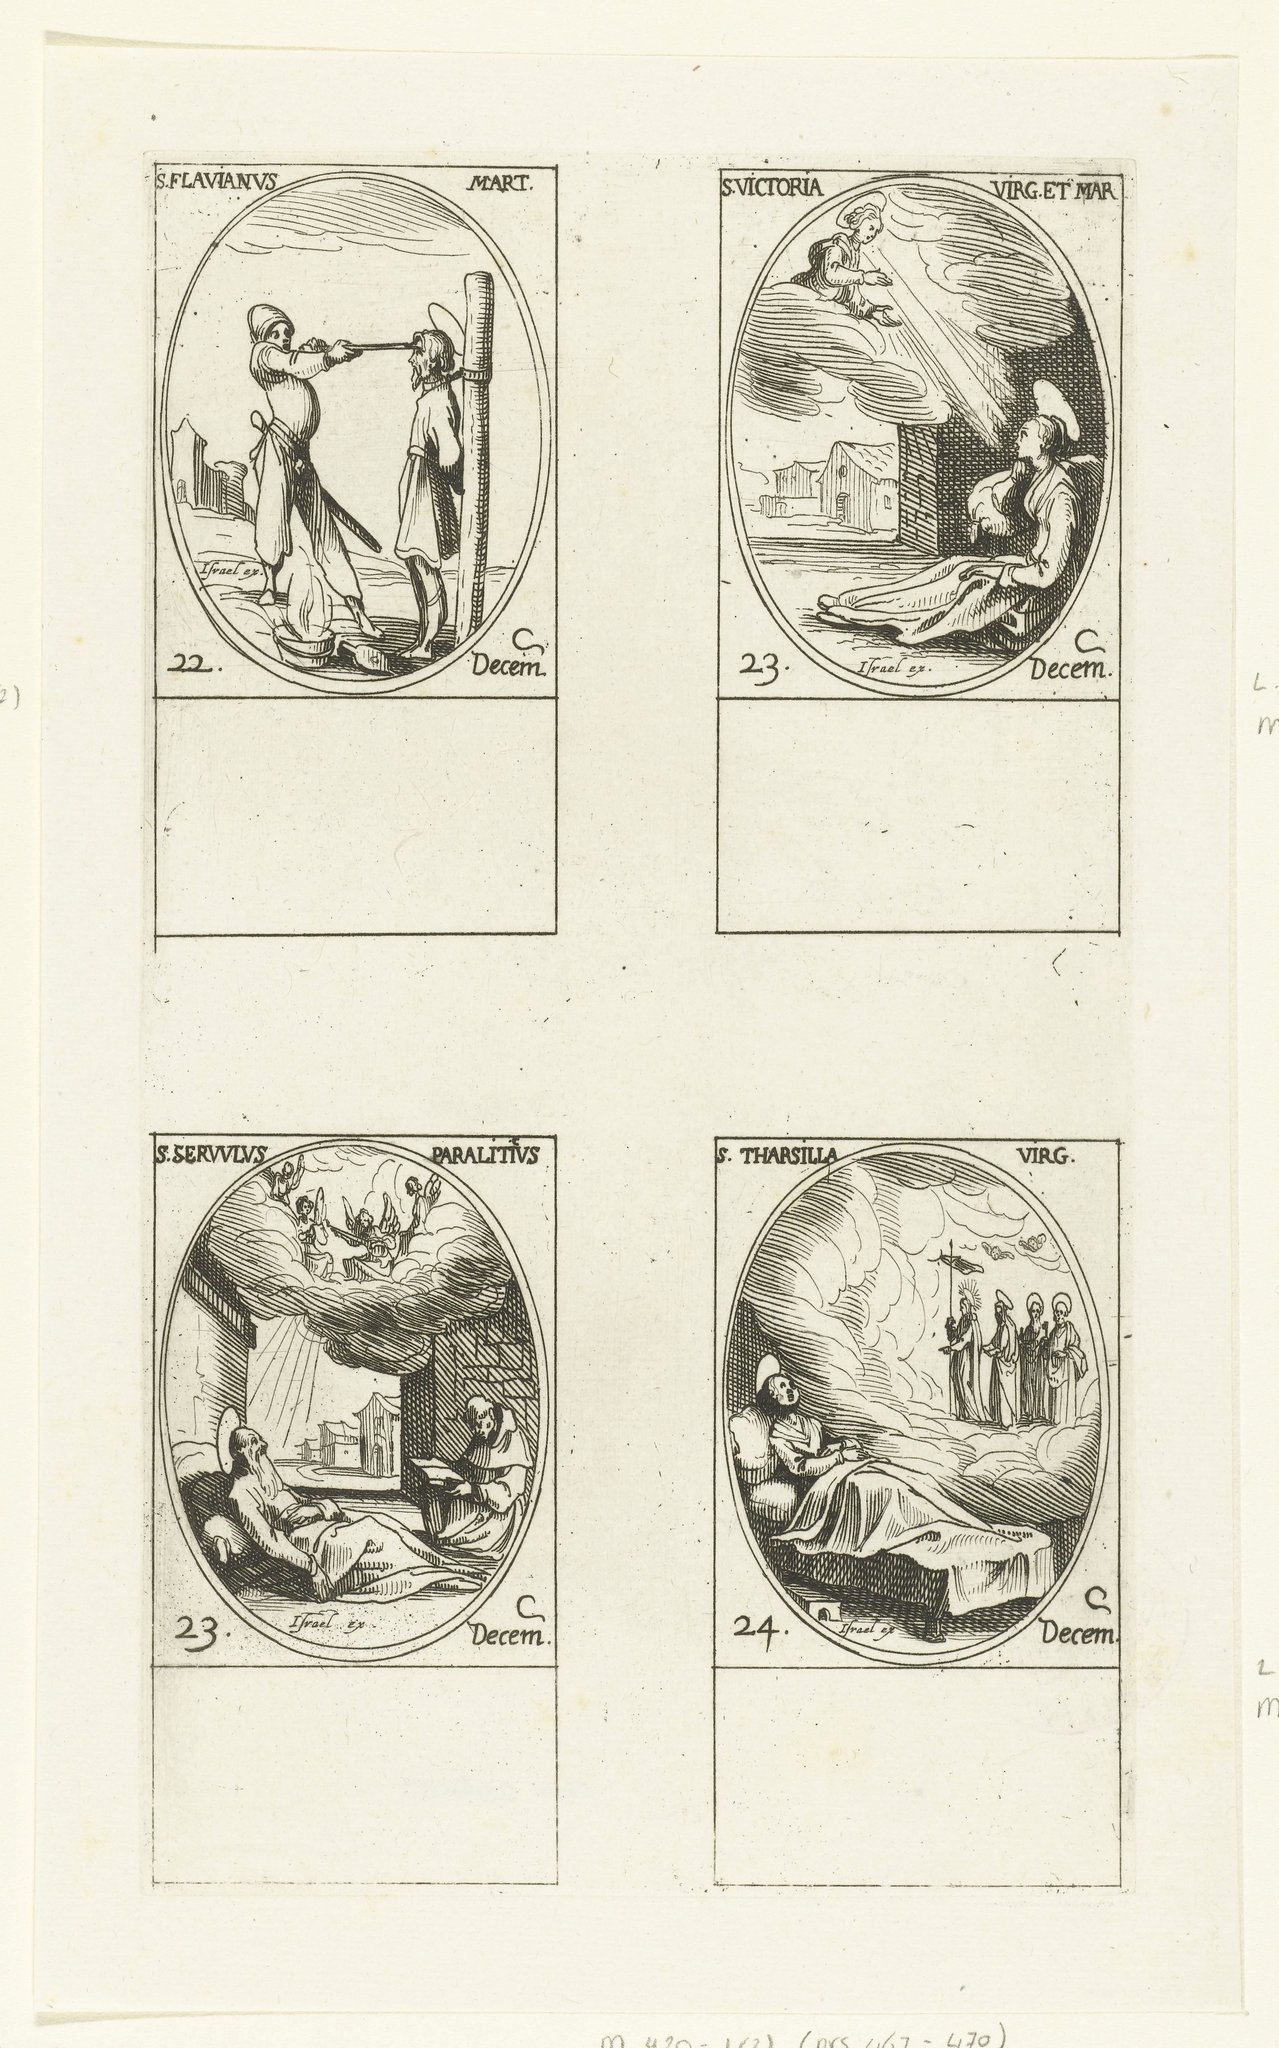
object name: print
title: Alle heiligen en de Christelijke feestdagen van het jaar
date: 1632-1636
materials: paper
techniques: etching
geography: nancy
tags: female saints (with name), male saints (with name)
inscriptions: collector's mark: Lugt 240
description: Blad met vier ovale voorstellingen, elk met opschrift en datum in het Latijn: linksboven de Heilige Flavianus van Acquapendente die gebrandmerkt wordt, rechtsboven de Heilige Victoria van Rome die een heilige vrouw (Maria?) in de hemel aanschouwt, linksonder de Heilige Servulus van Rome liggend op straat en engelen in de hemel aanschouwend, rechtsonder de Heilige Tarsilla van Rome liggend op een bed en heiligen in de hemel aanschouwend. Deze prent is onderdeel van een serie prenten met voorstellingen van de heiligen en de christelijke feestdagen van het jaar. Er zijn steeds vier scènes van één plaat op één blad gedrukt. Inclusief bijbehorend titelblad en frontispice gaat het in totaal om 124 platen (490 voorstellingen). De drie platen met de laatste 12 scènes (de veranderlijke christelijke feestdagen) zijn in de derde staat versneden tot 12 kleine plaatjes, en met een apart titelblad uitgegeven.